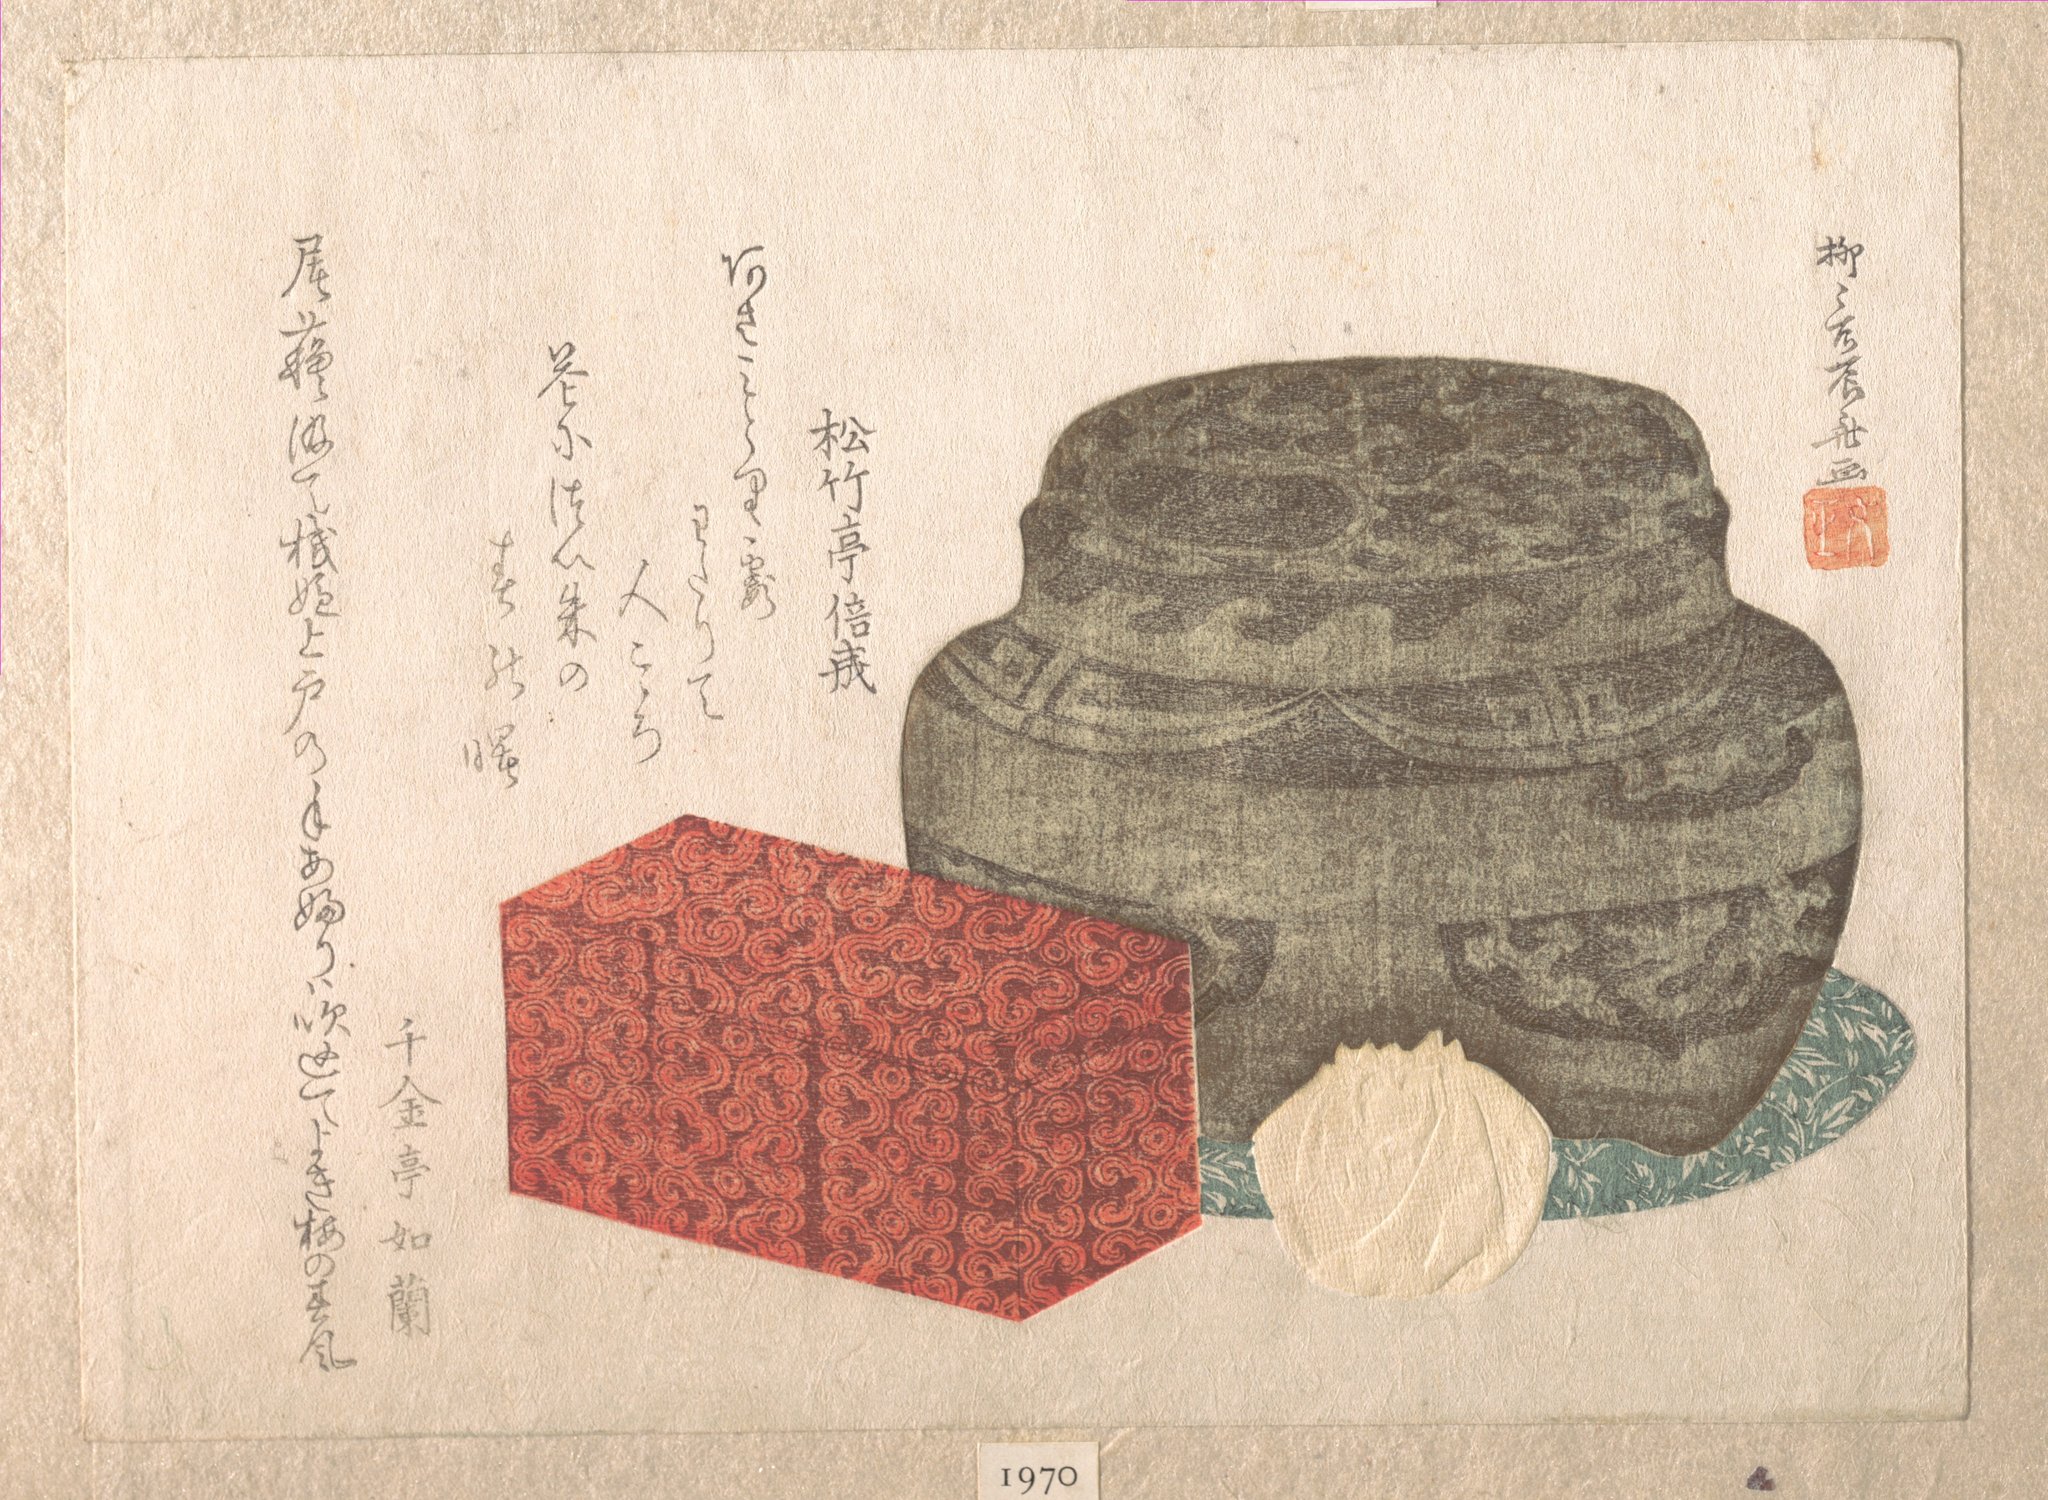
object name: woodblock print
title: Fire-Holder and Tea-Box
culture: japanese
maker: ryūryūkyo shinsai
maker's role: artist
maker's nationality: japanese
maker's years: 1799-1823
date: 1801-1900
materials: ink, paper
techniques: surimono, woodblock print